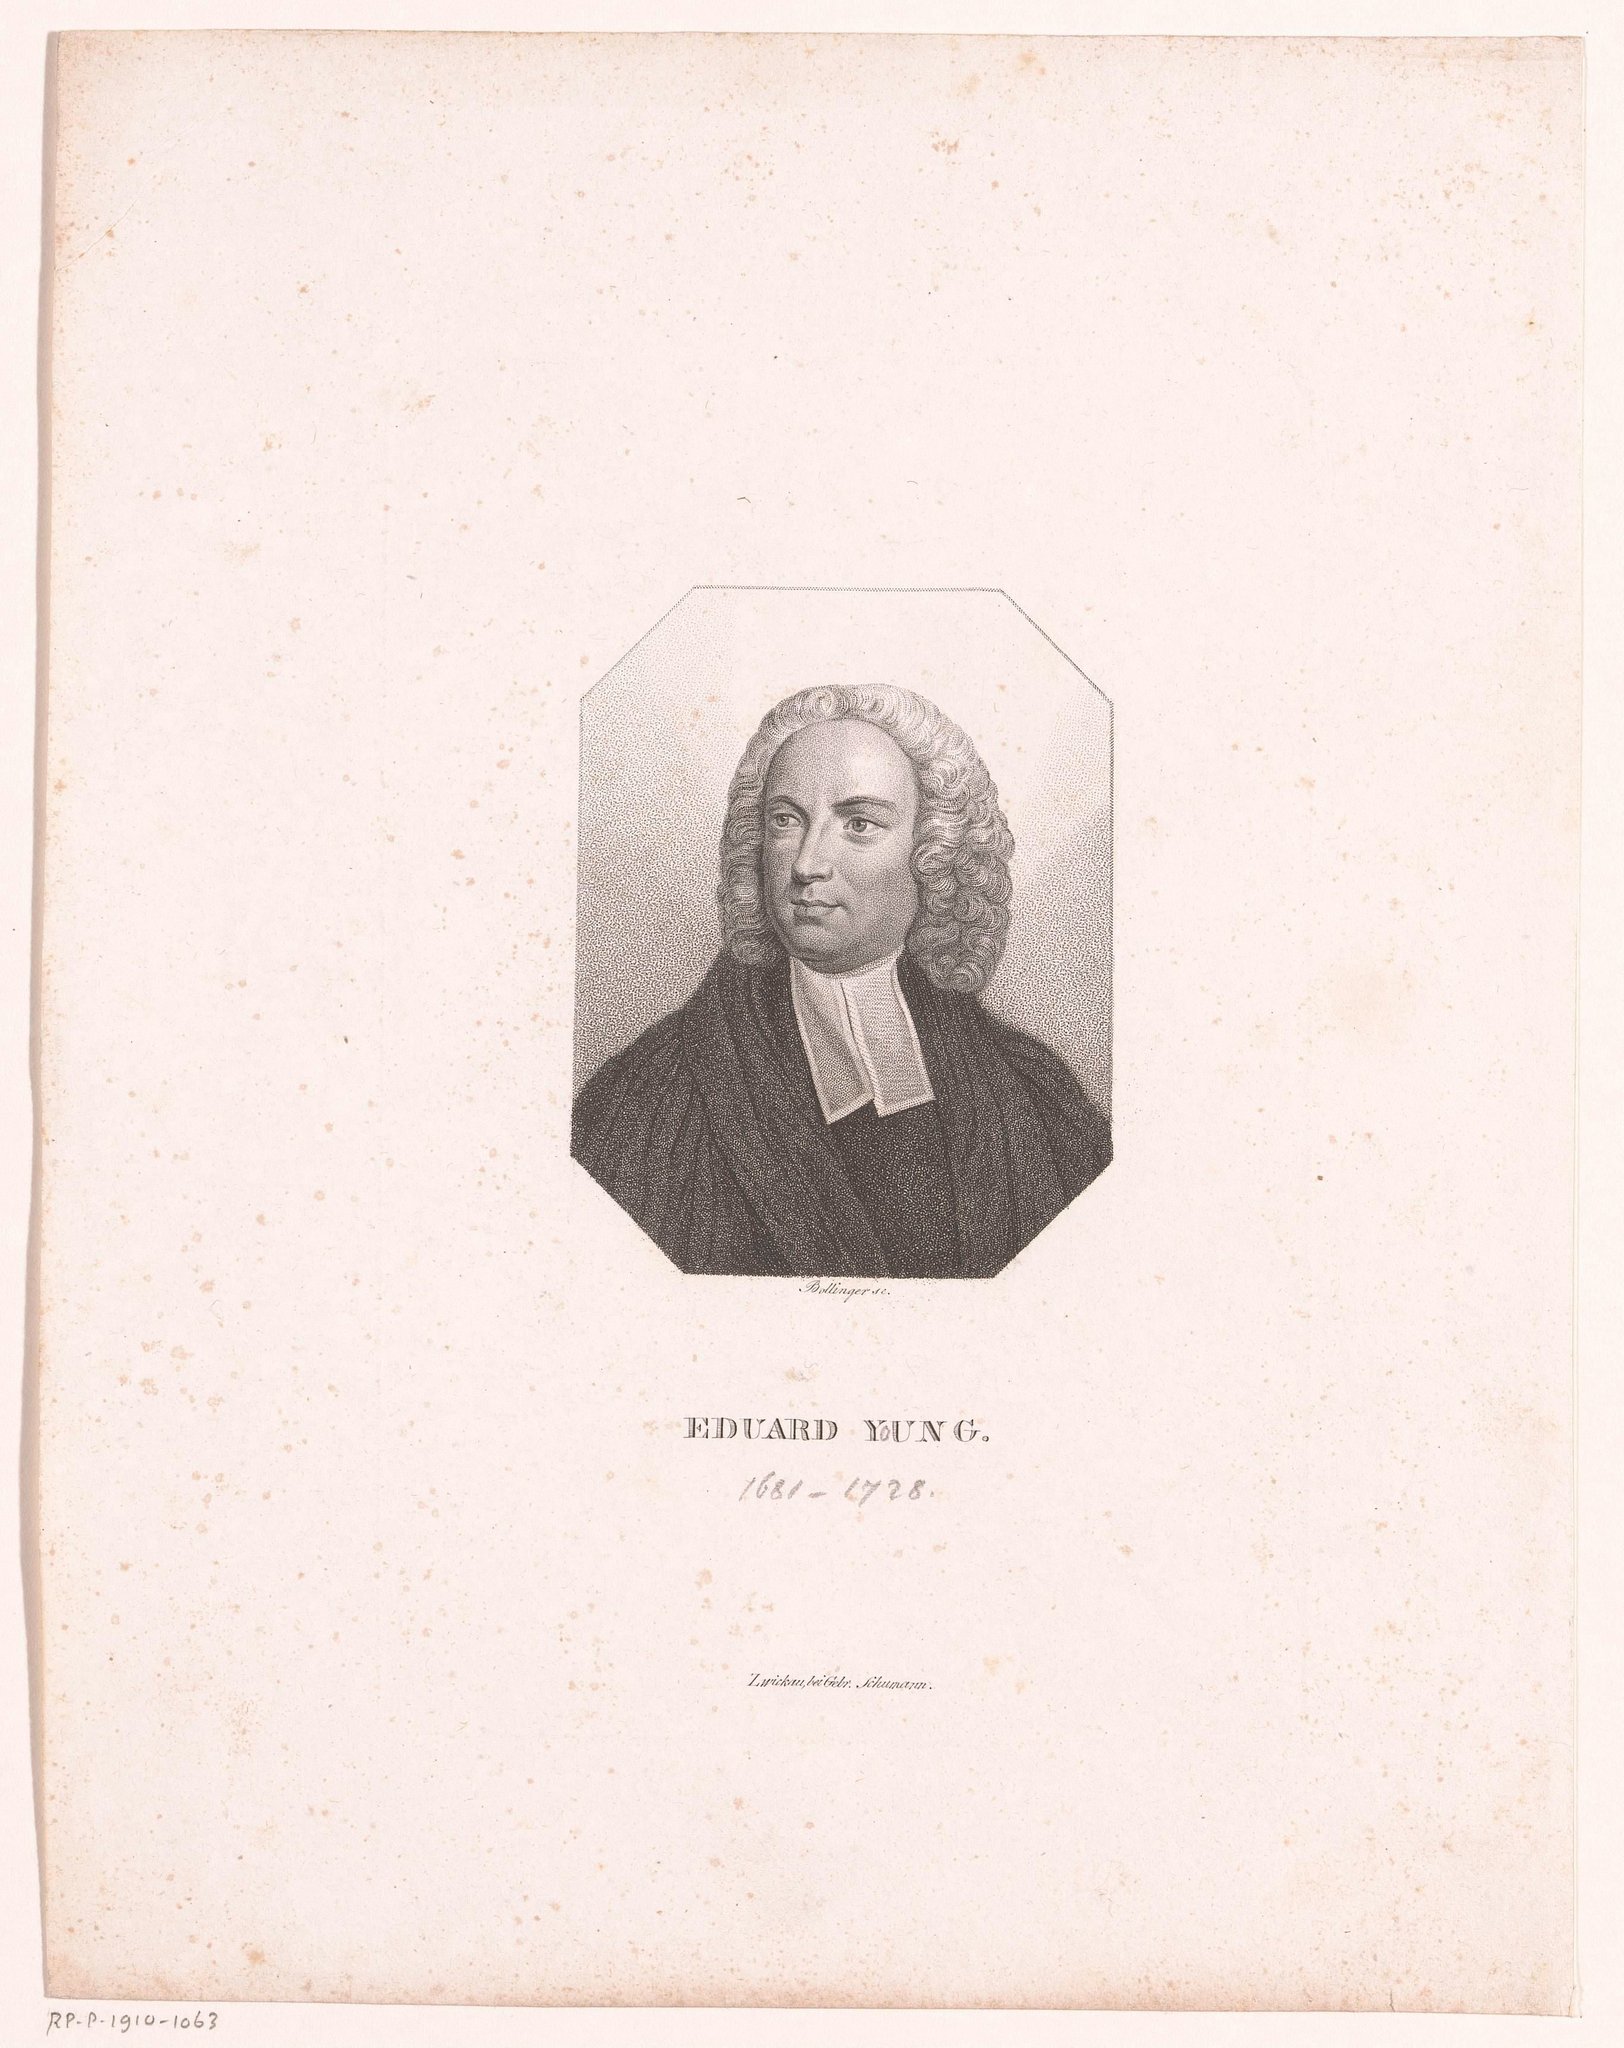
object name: print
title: Portret van Edward Young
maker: friedrich wilhelm bollinger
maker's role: print maker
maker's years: 1777-1825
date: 1818-1832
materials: paper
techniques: stippling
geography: berlin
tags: edward young, historical persons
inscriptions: collector's mark: Lugt 2228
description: Prent gebruikt door de serie 'Bildnisse der berühmtesten Menschen aller Völker und Zeiten' van de gebroeders Schumann, uitgegeven in 1818-1832 te Zwickau.